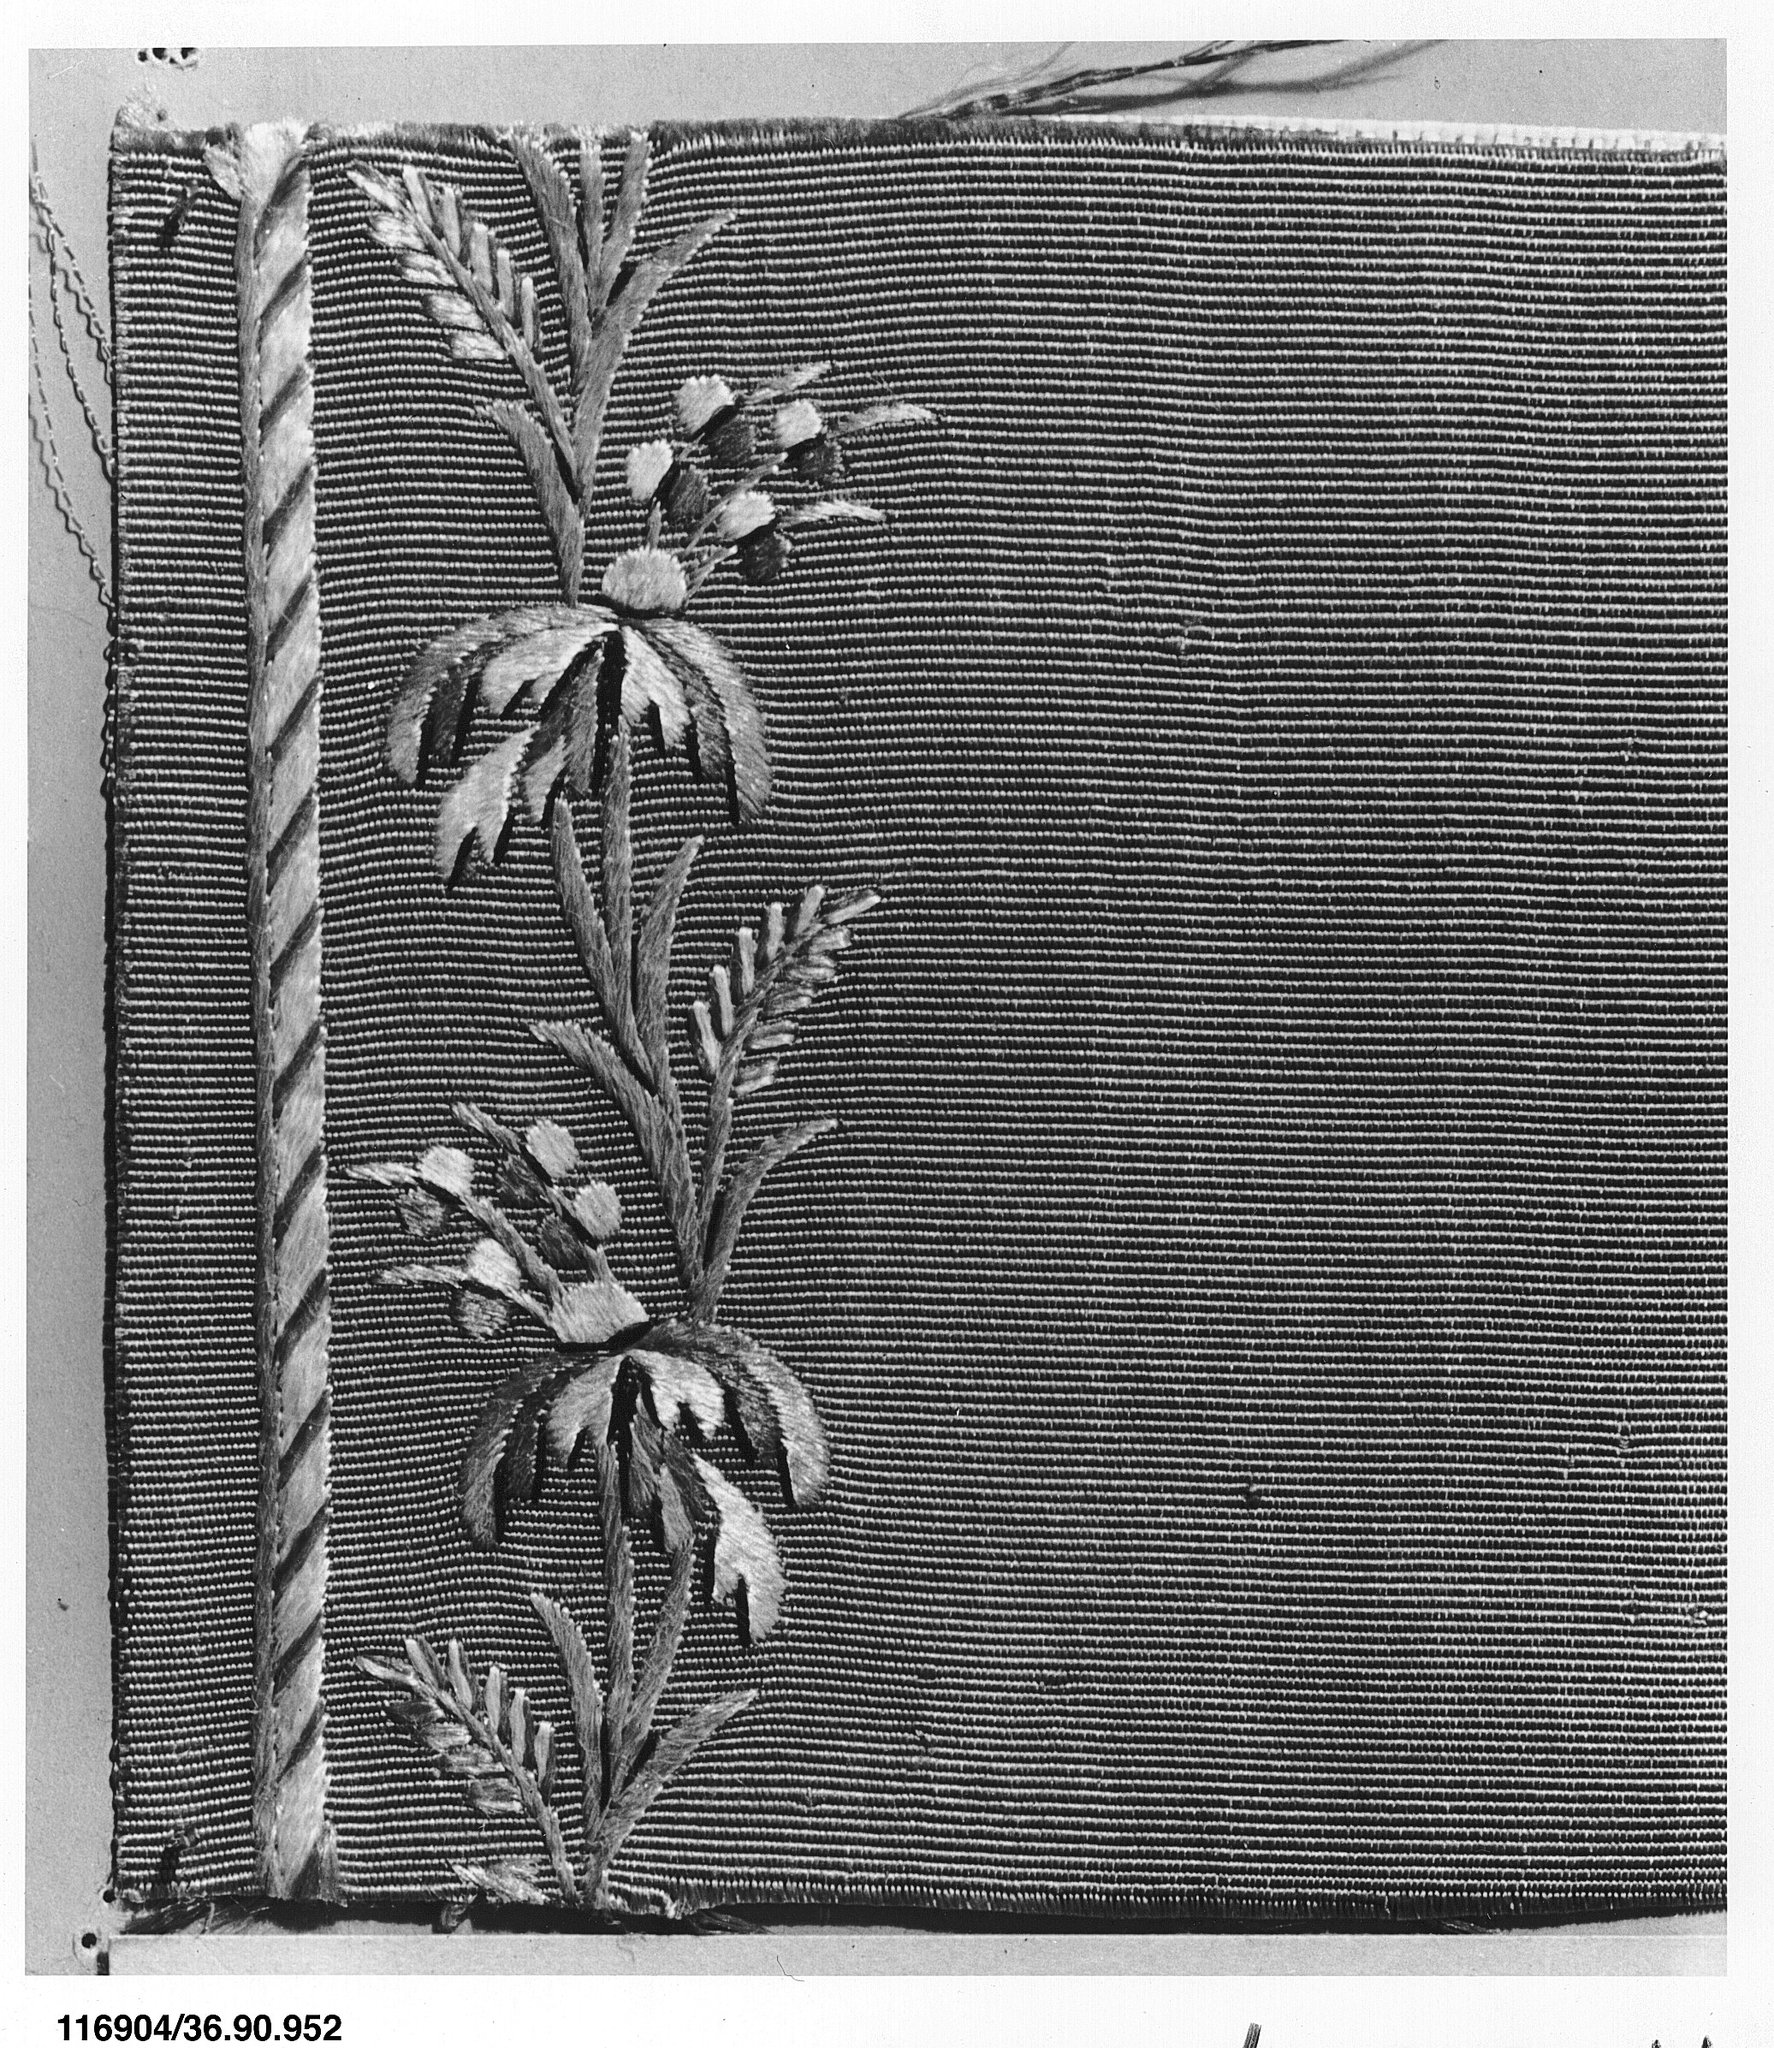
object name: sample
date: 1801-1833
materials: silk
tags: plants